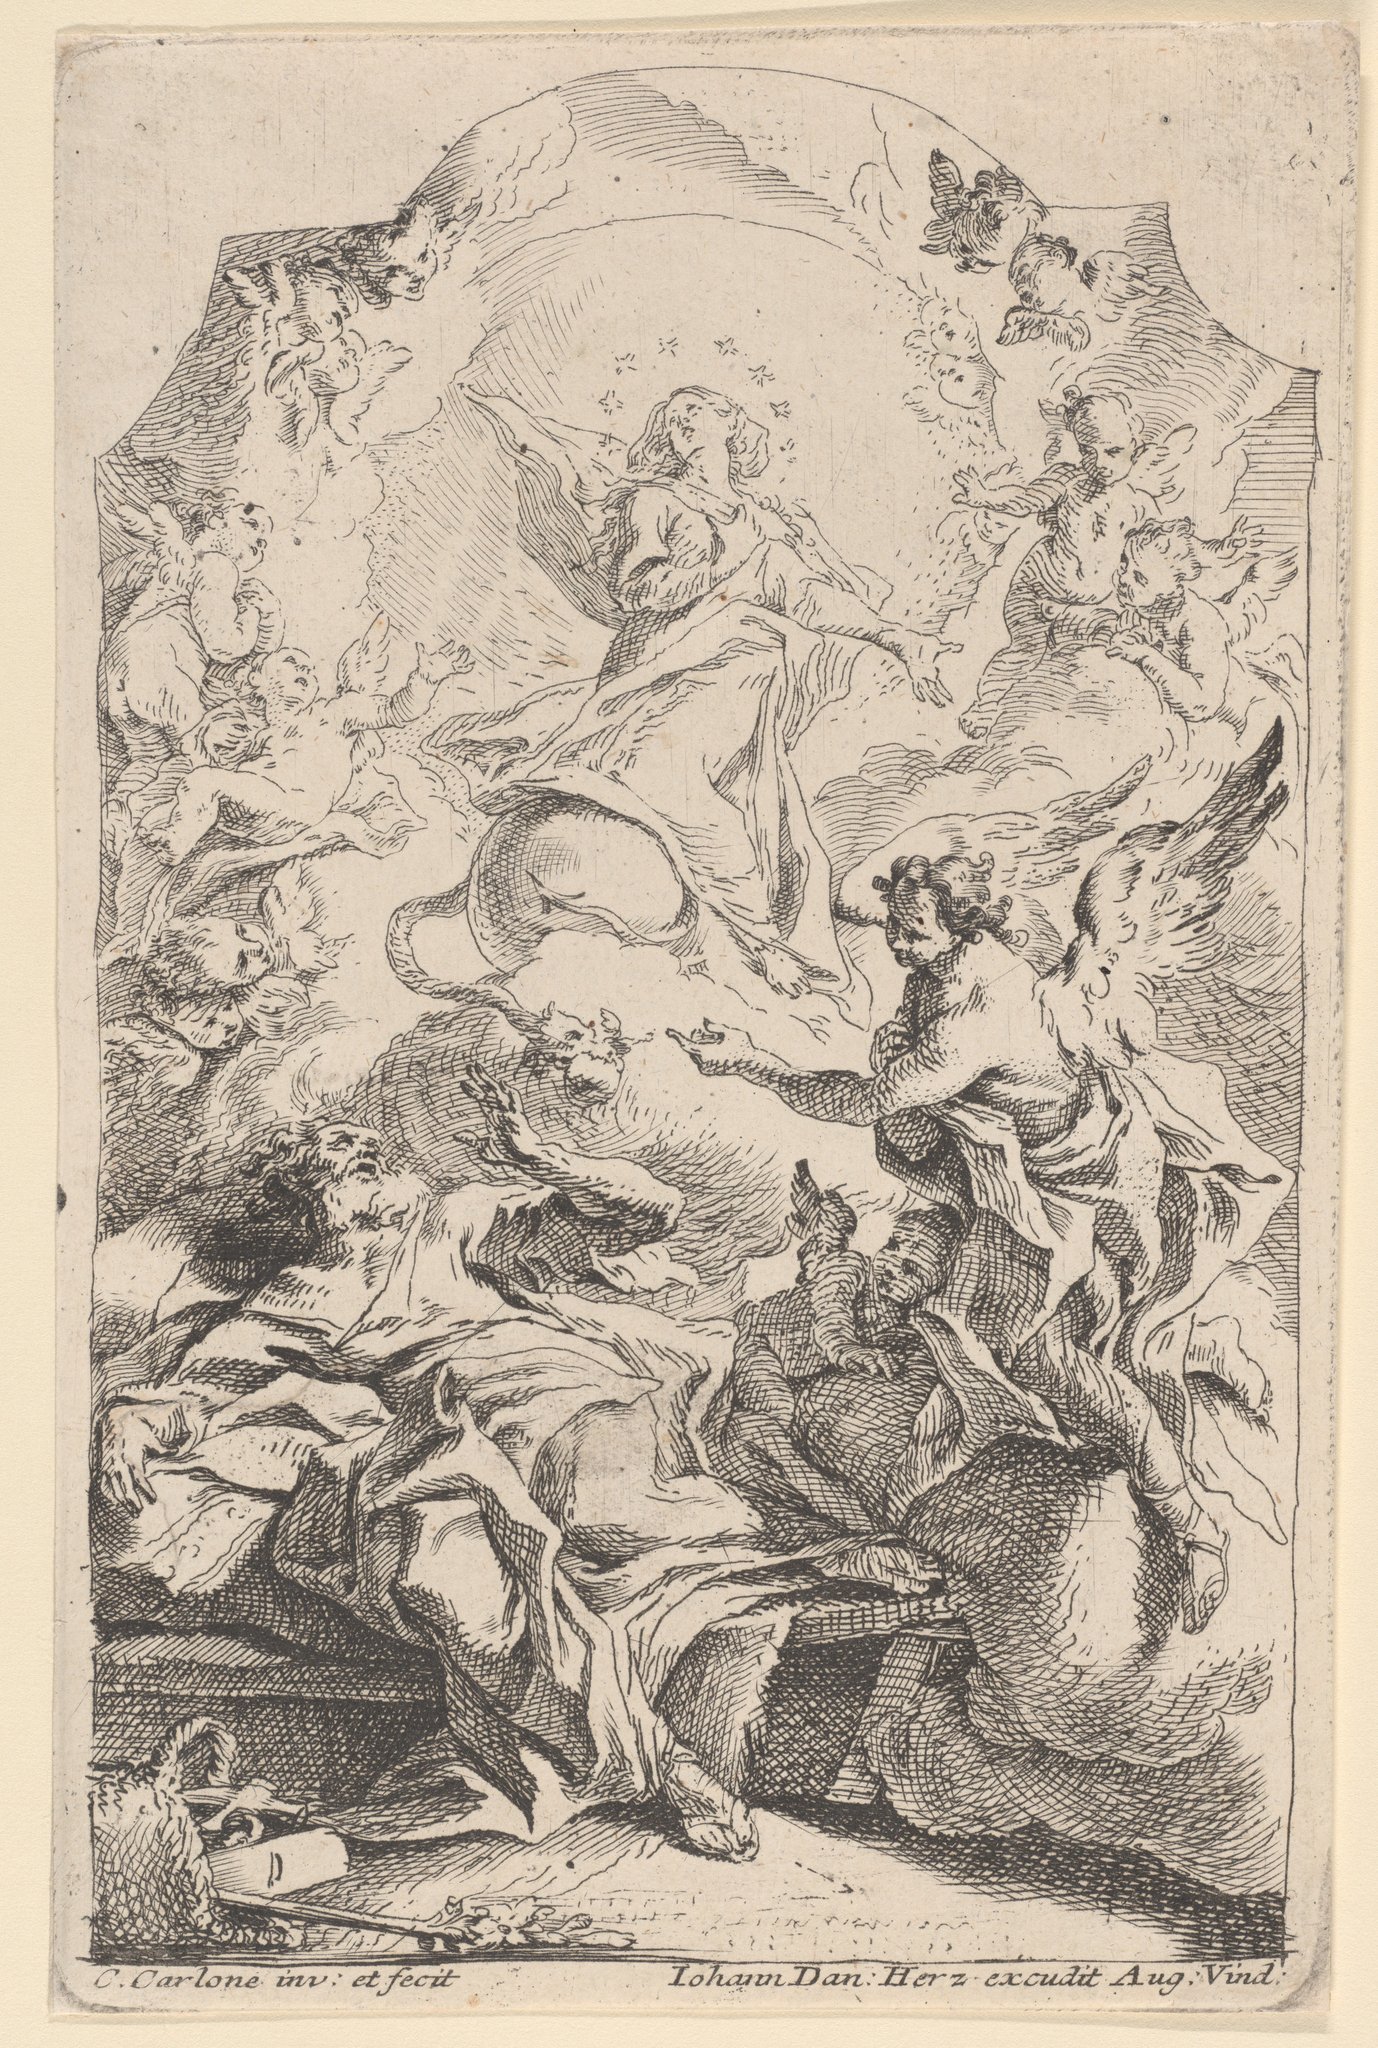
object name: print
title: The Annunciation to Saint Joseph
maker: carlo innocenzo carloni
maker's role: artist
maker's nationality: italian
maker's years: 1686-1775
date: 1725-1775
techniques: etching